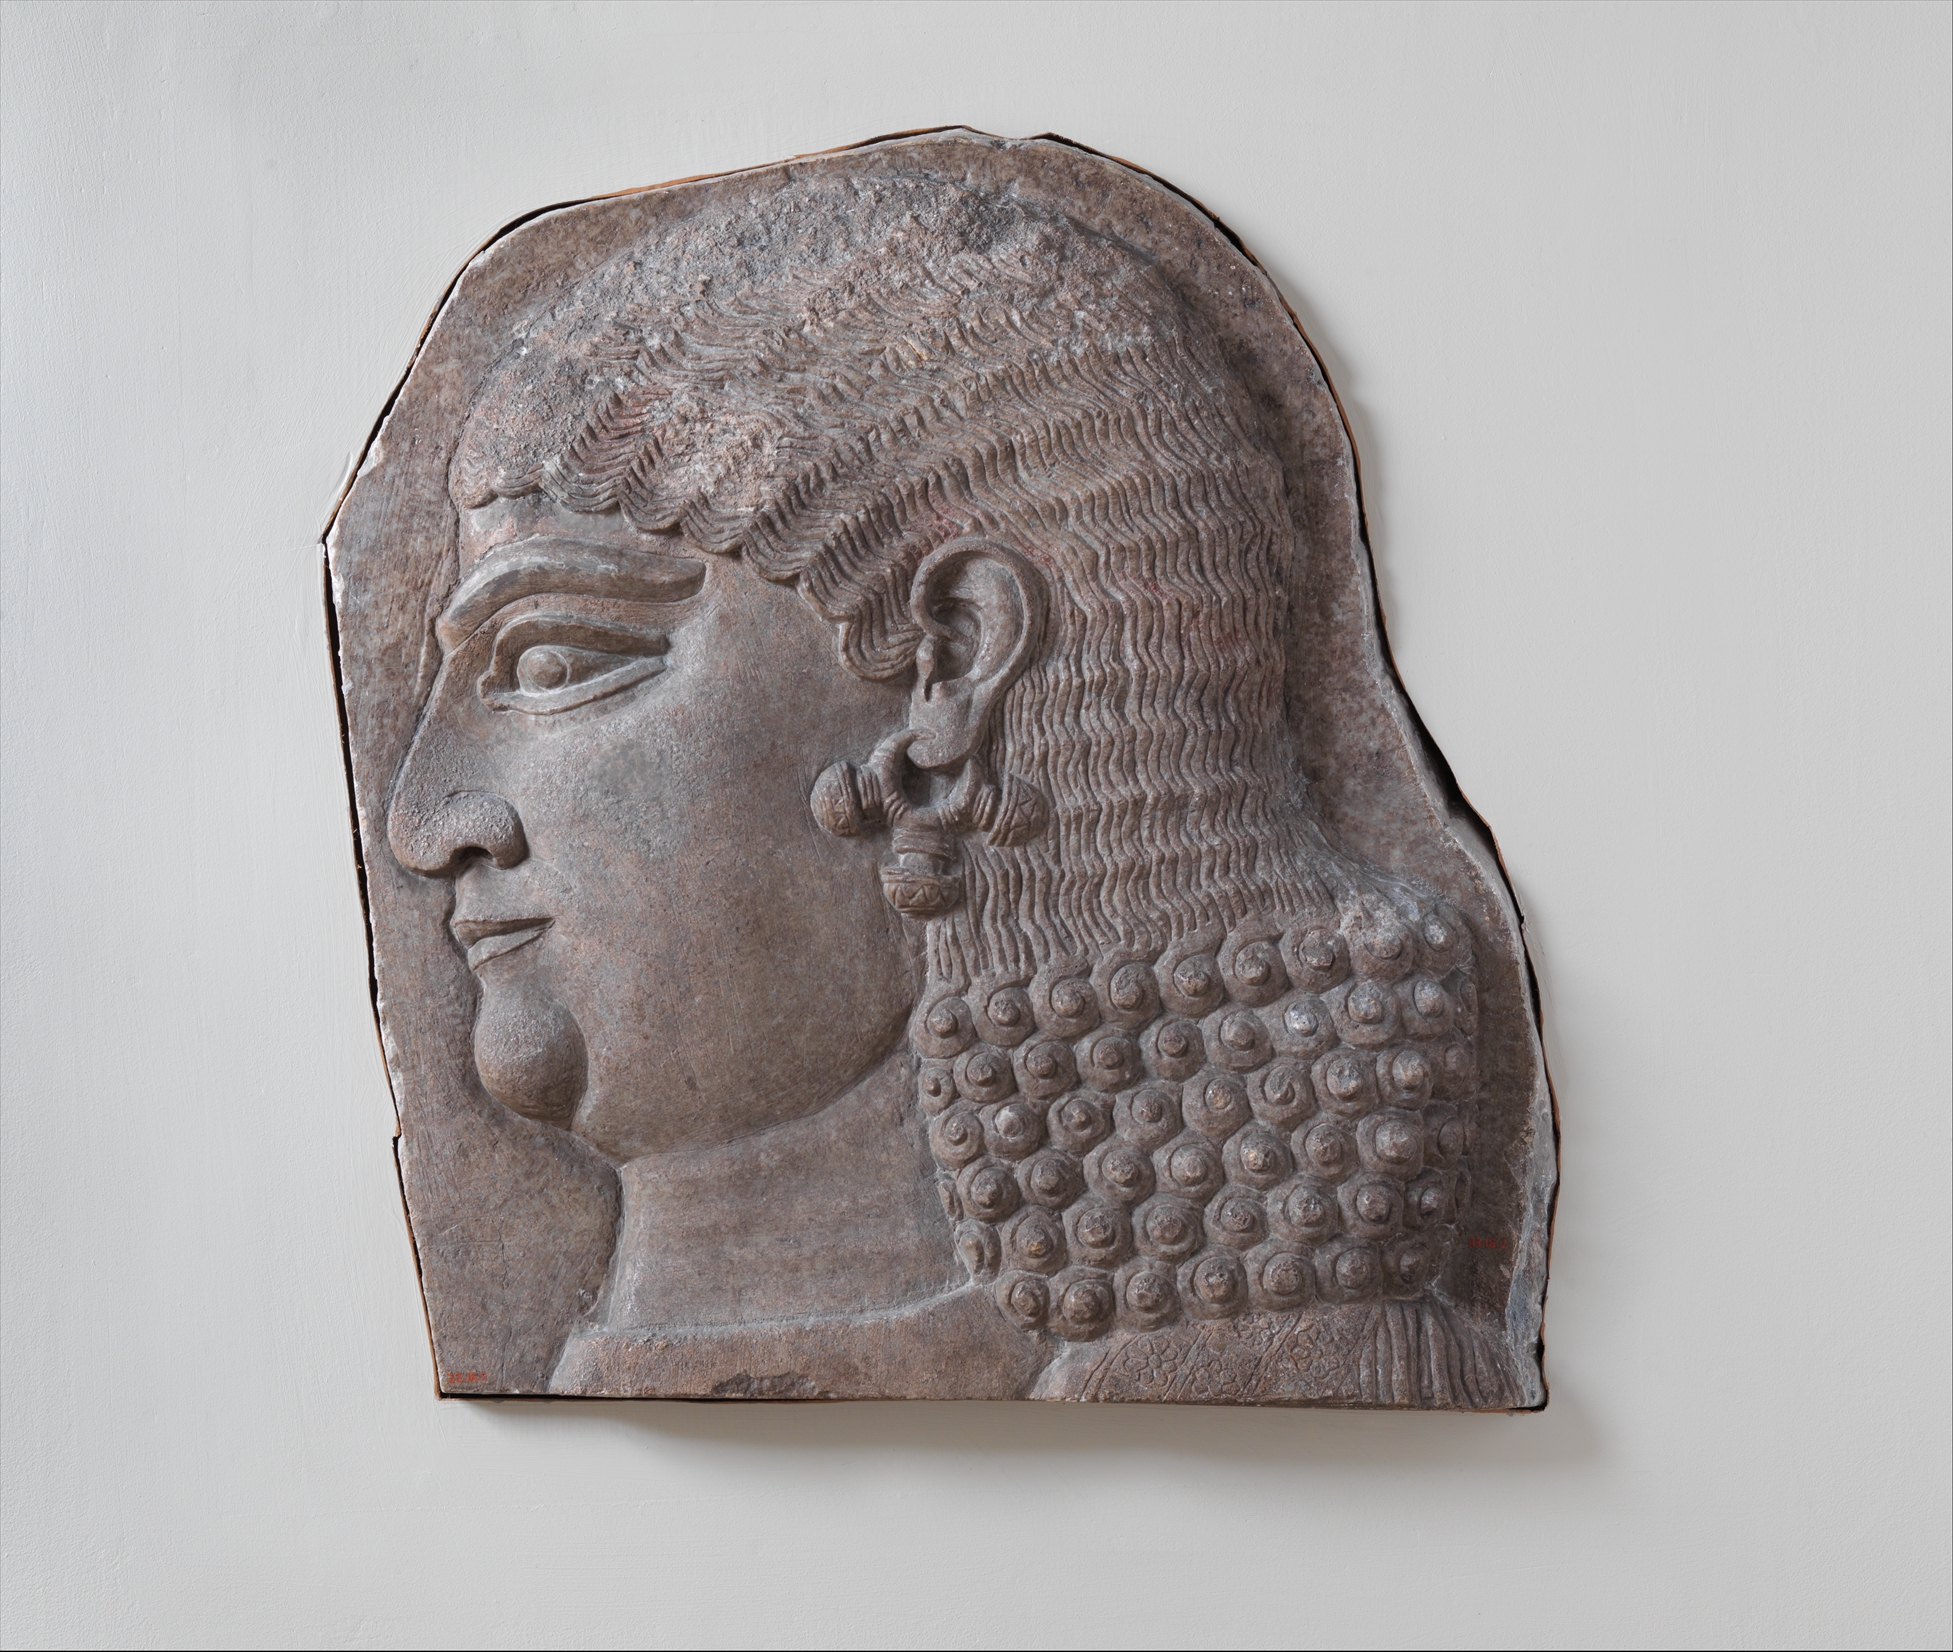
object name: relief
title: Head of a beardless royal attendant, possibly a eunuch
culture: assyrian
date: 721-705 BCE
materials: alabaster, gypsum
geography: mesopotamia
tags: heads,men